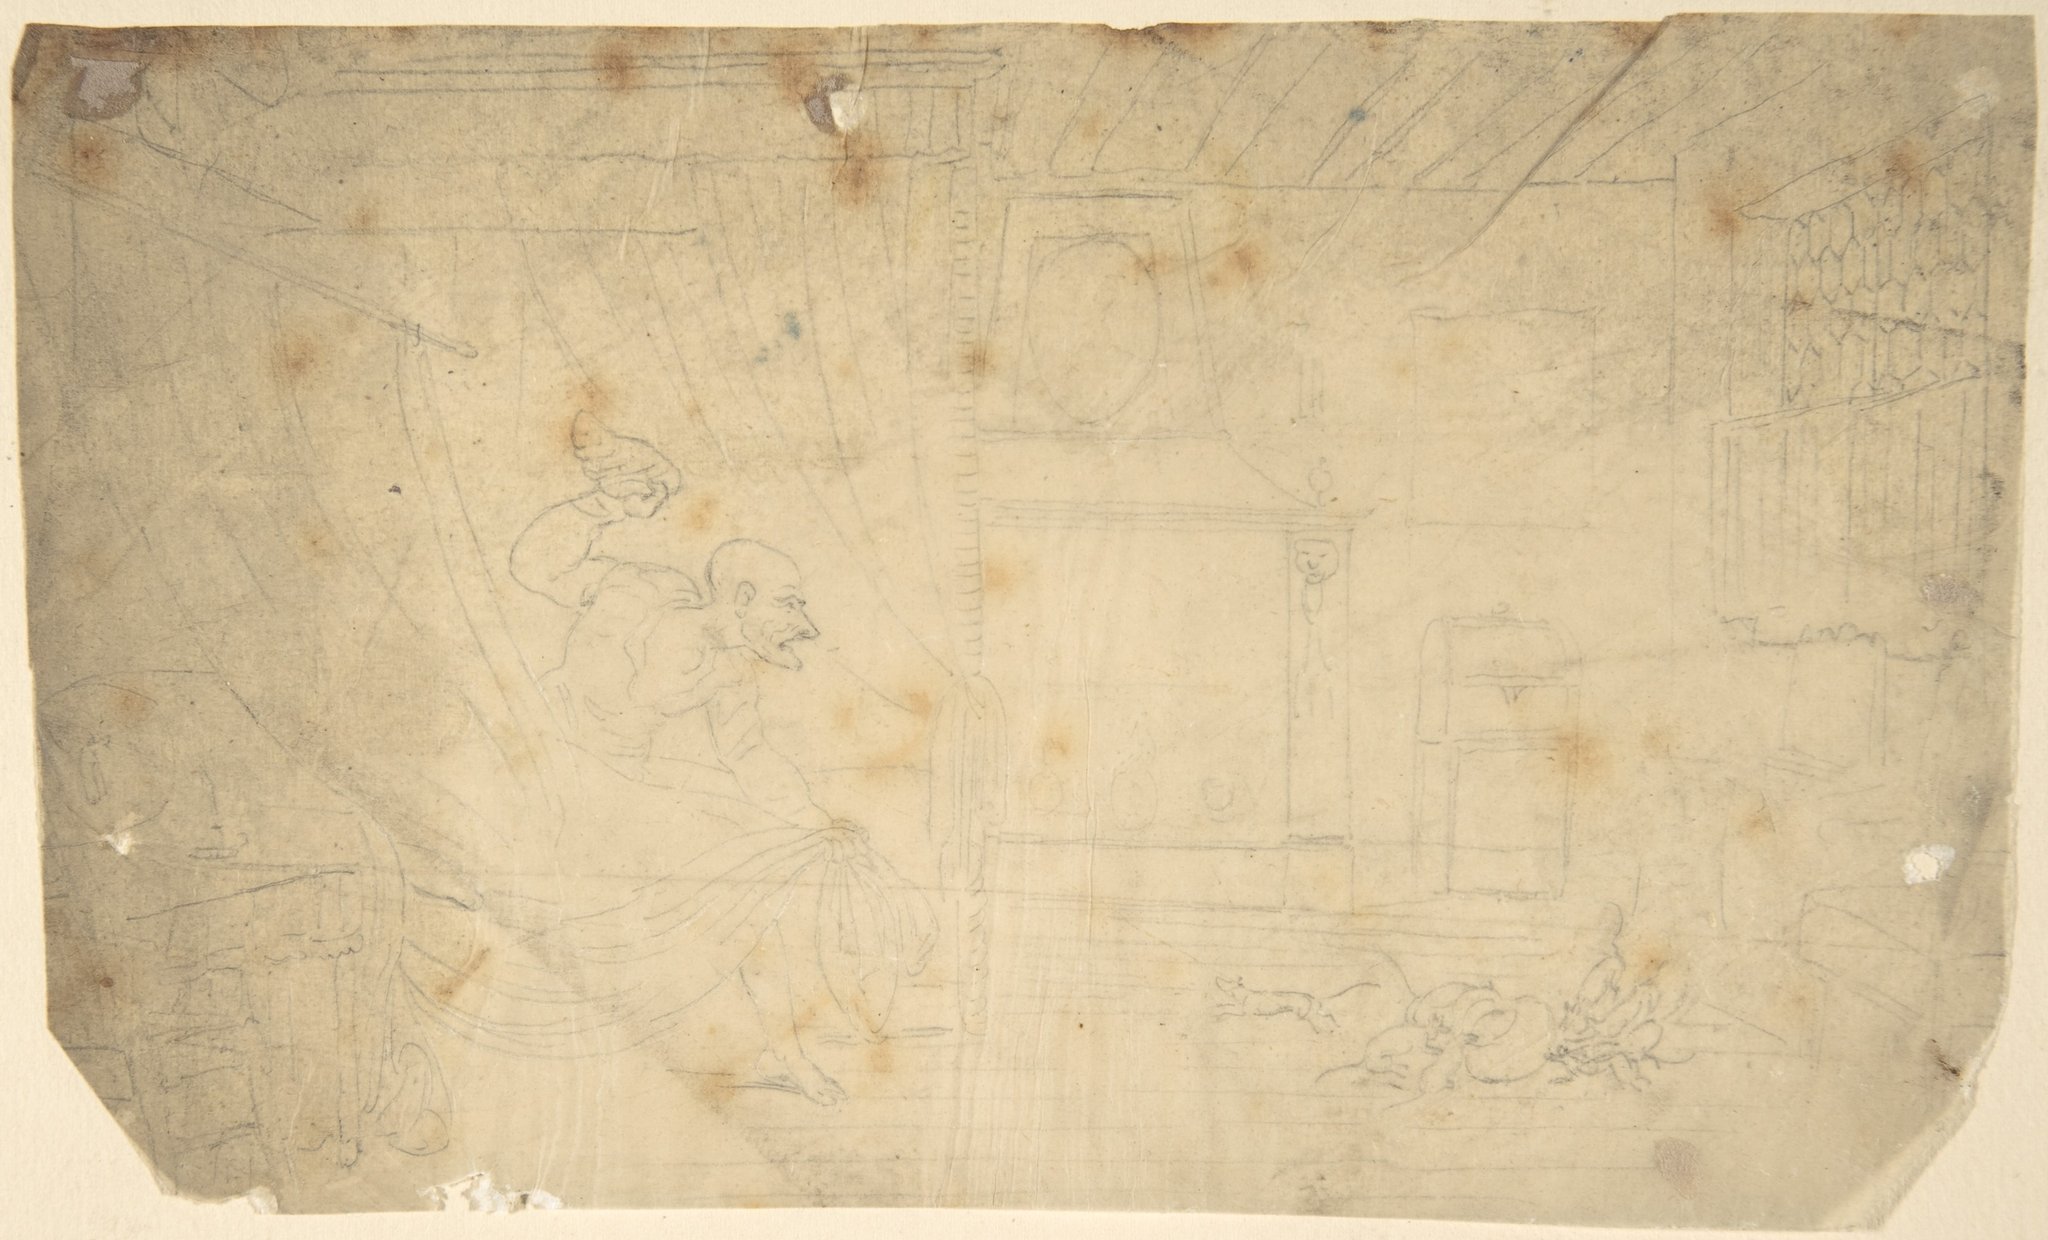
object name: drawing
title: Dr. Syntax Loses His Wig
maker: thomas rowlandson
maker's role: artist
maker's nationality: british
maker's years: 1757-1827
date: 1820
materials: graphite, paper